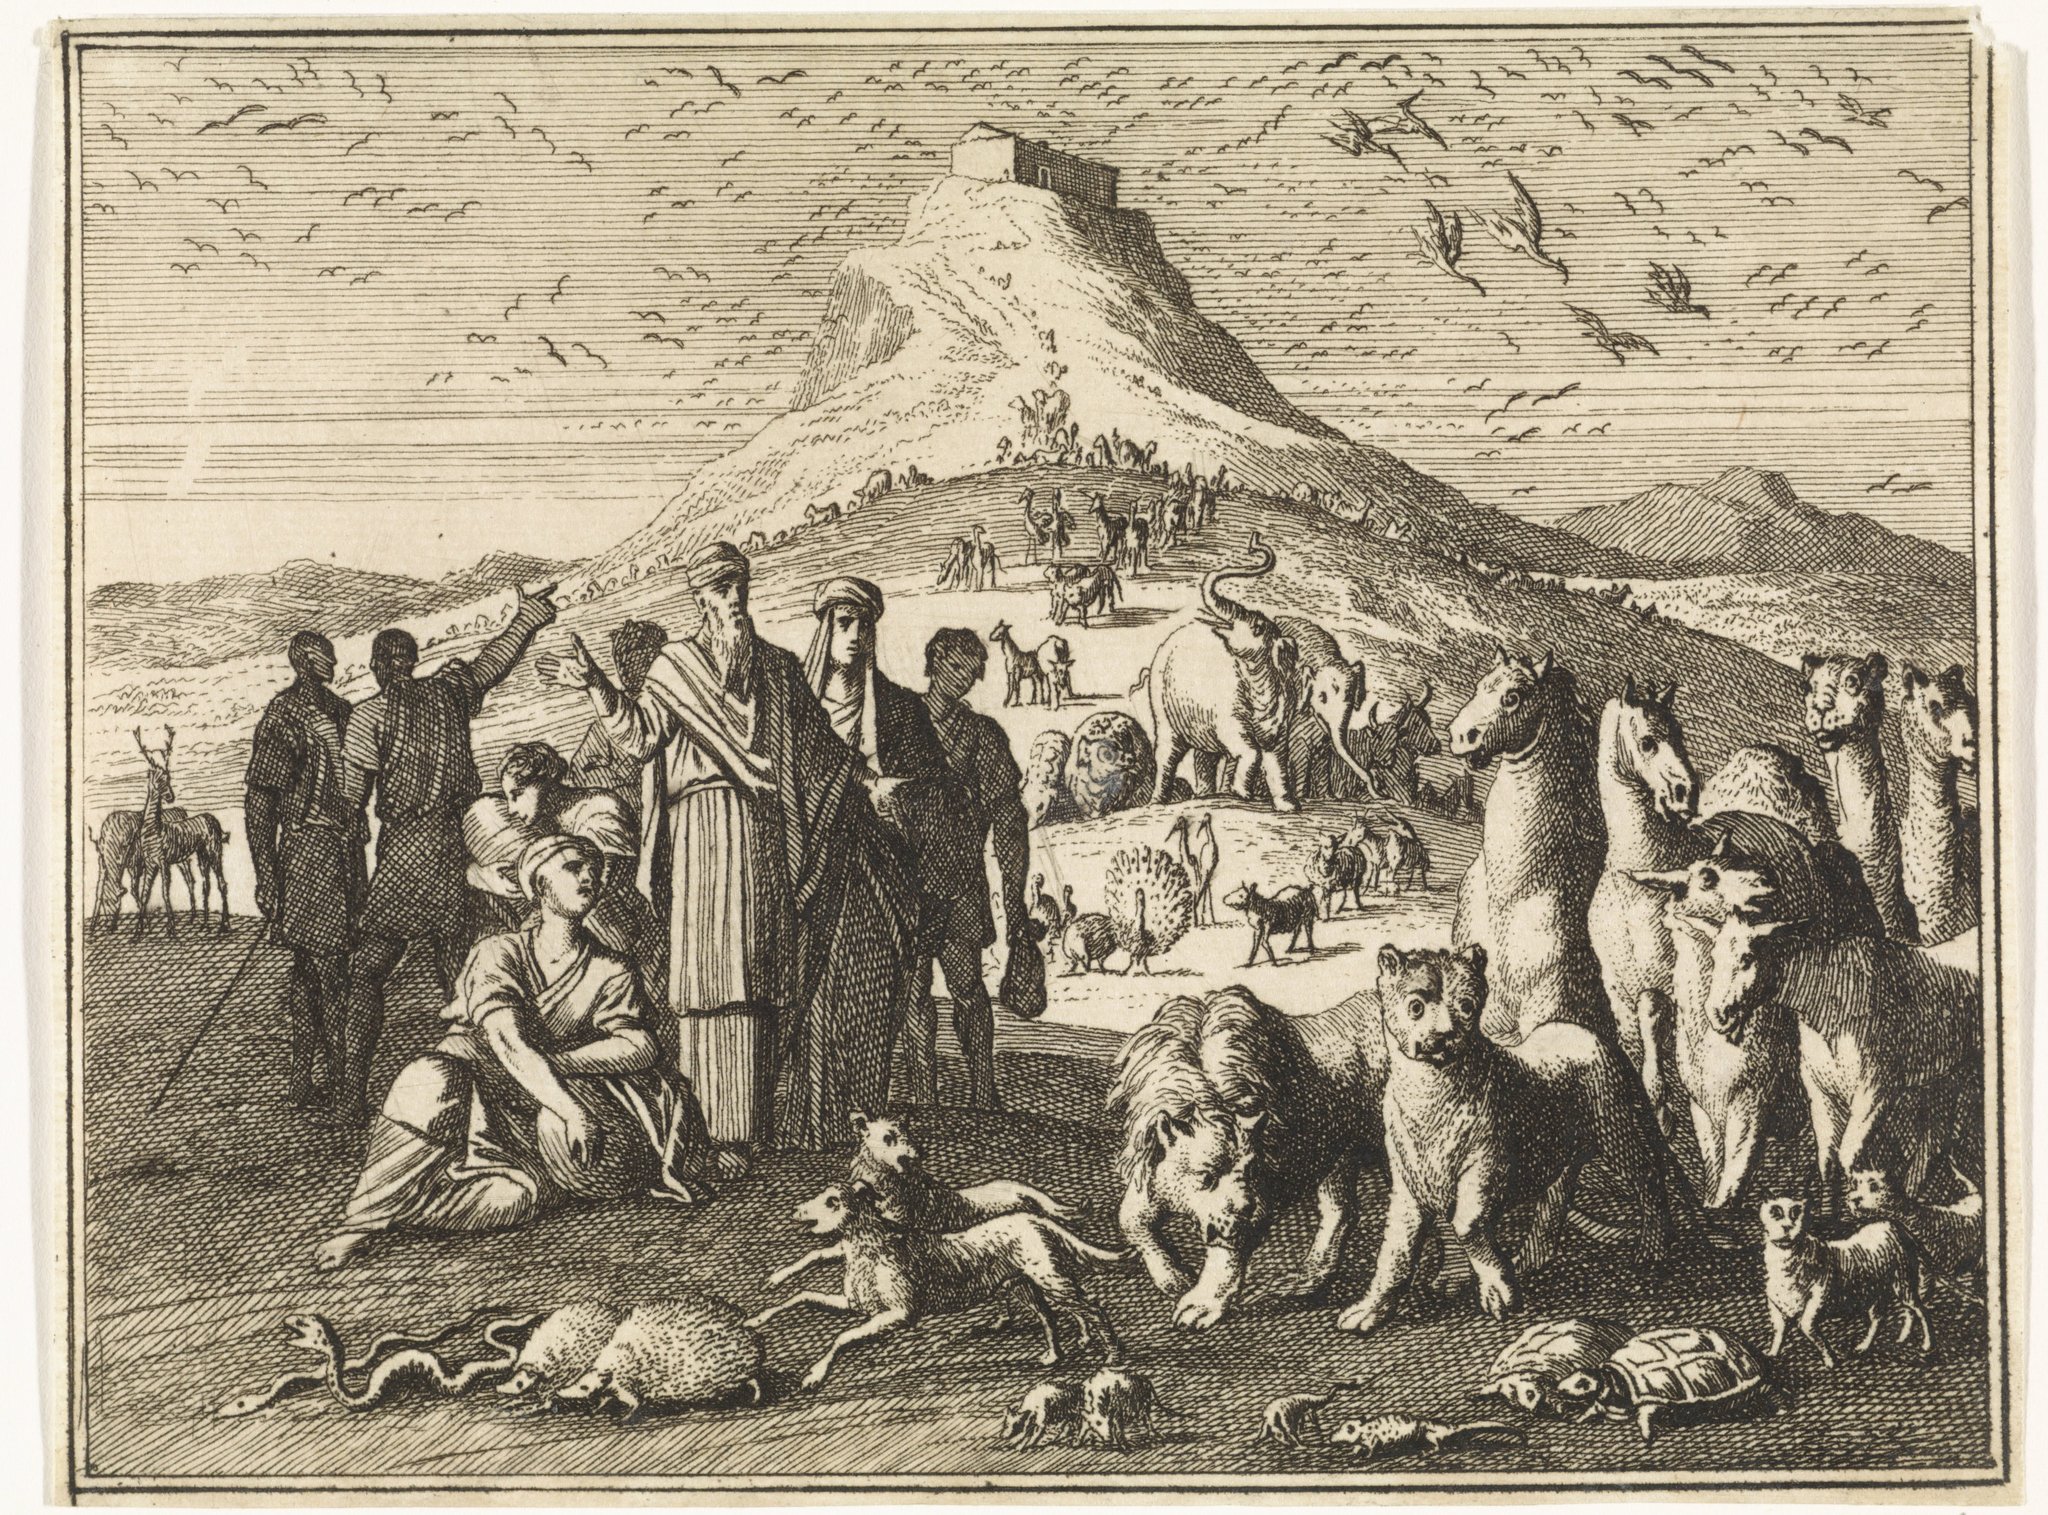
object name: print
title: Noach, zijn familie en de dieren verlaten de ark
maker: caspar luyken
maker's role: draughtsman, print maker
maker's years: 1672-1708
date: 1712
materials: paper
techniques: etching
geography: amsterdam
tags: the disembarkation ~ story of noah (genesis 8:18 - 9:17)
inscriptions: collector's mark: Lugt 2228, number: ‘14’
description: Illustratie uit: Luyken, Jan. De schriftuurlyke geschiedenissen en gelykenissen van het Oude en Nieuwe Verbond, 2 delen. Amsterdam: Wed. Pieter Arentsz II en Cornelis van der Sys, 1712, dl. I.